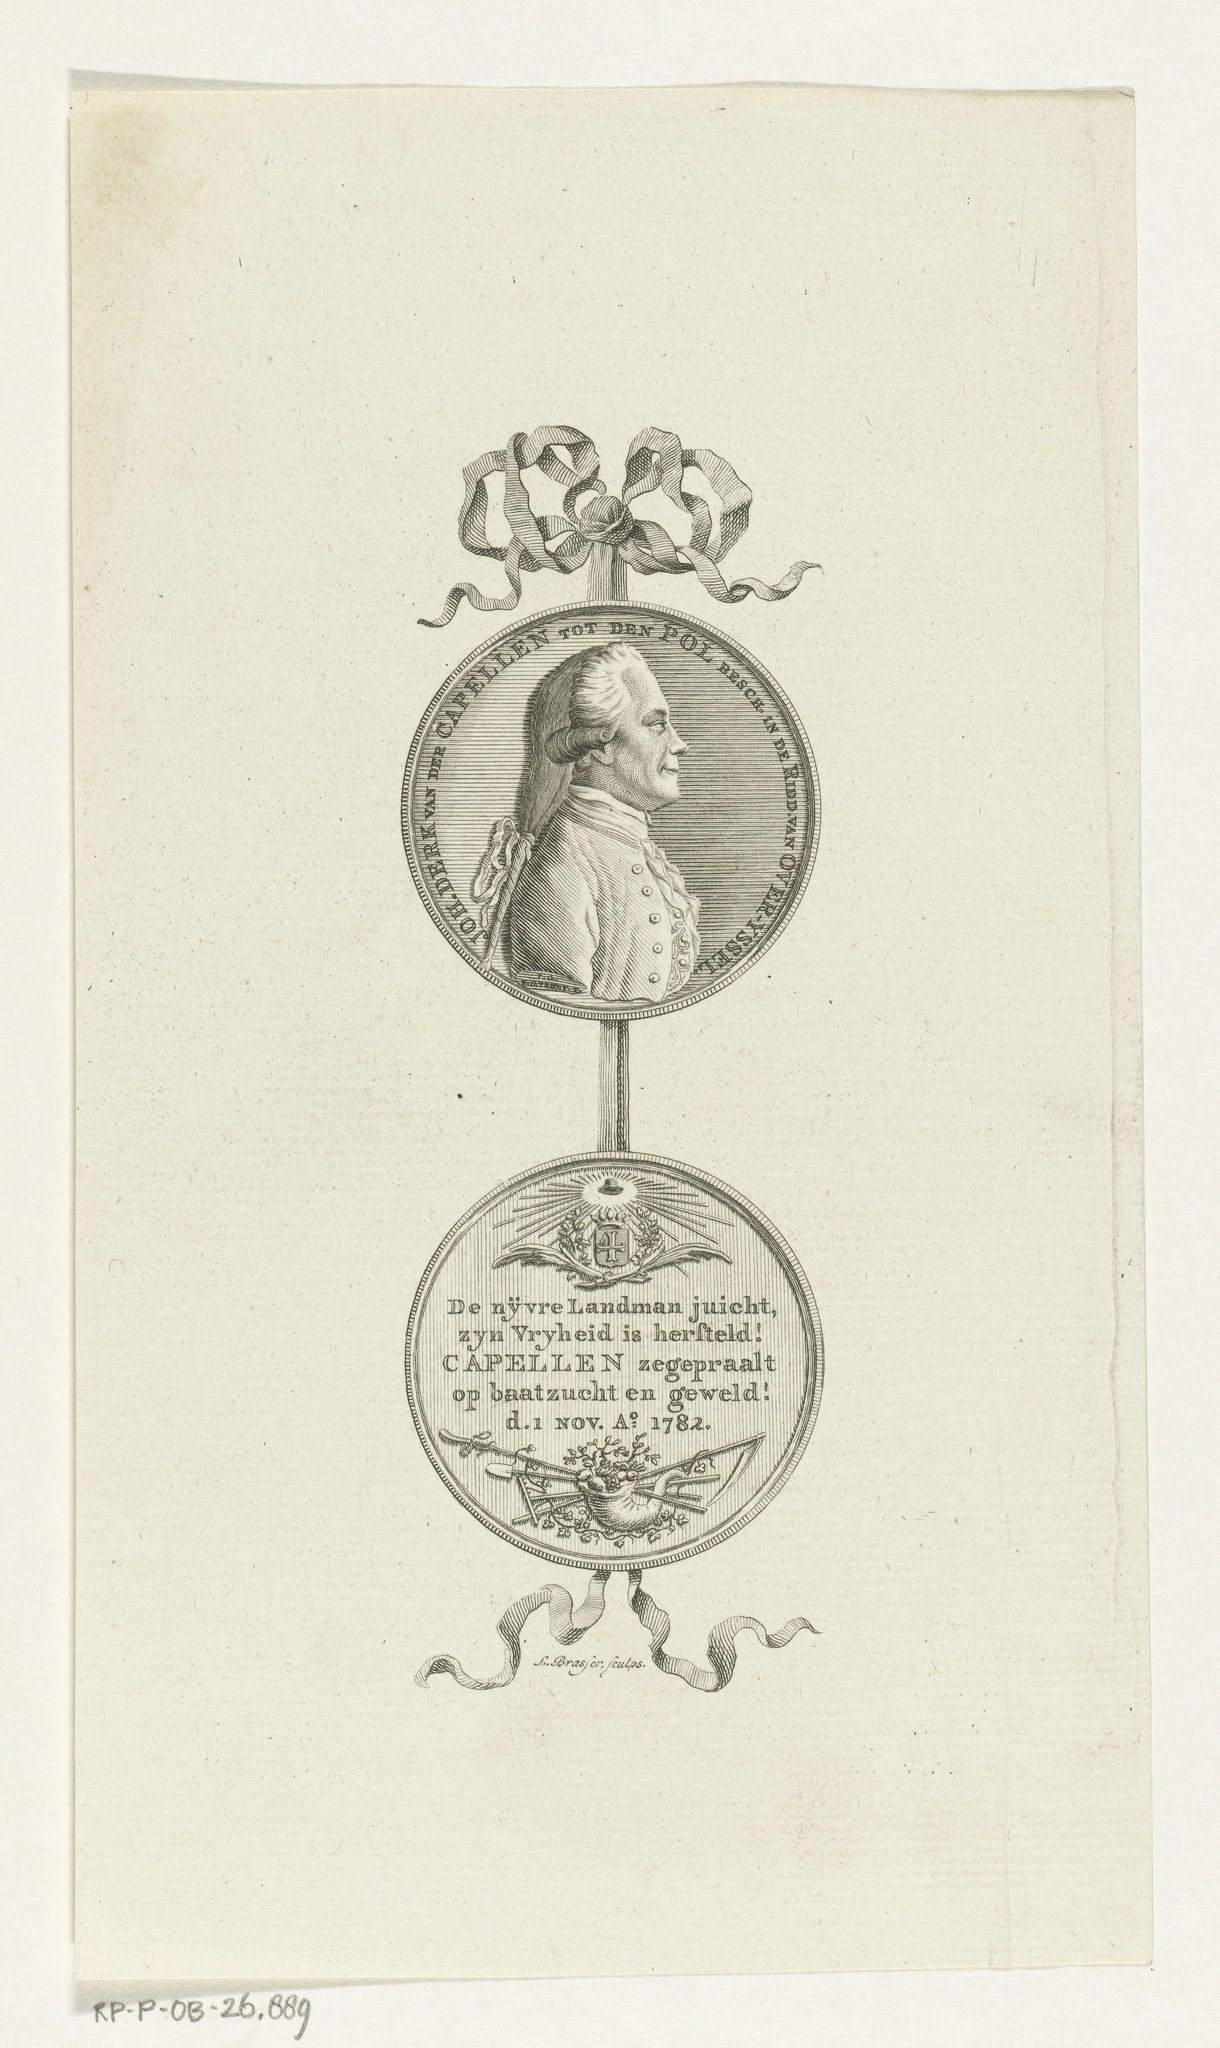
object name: print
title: Penning met portret van Johan Derk van der Capellen tot den Pol, 1 november 1782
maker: leendert brasser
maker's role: draughtsman, print maker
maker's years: 1727-1793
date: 1782-1783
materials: paper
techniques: engraving, etching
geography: rotterdam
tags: politician, joan derk van der capellen tot den pol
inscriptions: collector's mark: Lugt 2228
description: Penning hangend aan lint met op voorzijde portret van Johan Derk van der Capellen tot den Pol en opschrift dat verwijst naar zijn terugkeer naar de Staten van Overijssel op 1 november 1782, op achterzijde kort vers ter ere van deze politicus met datum van deze gebeurtenis. De gedenkpenning werd uitgereikt ter nagedachtenis aan het afschaffen van de drostendiensten te Overijssel in februari 1783.